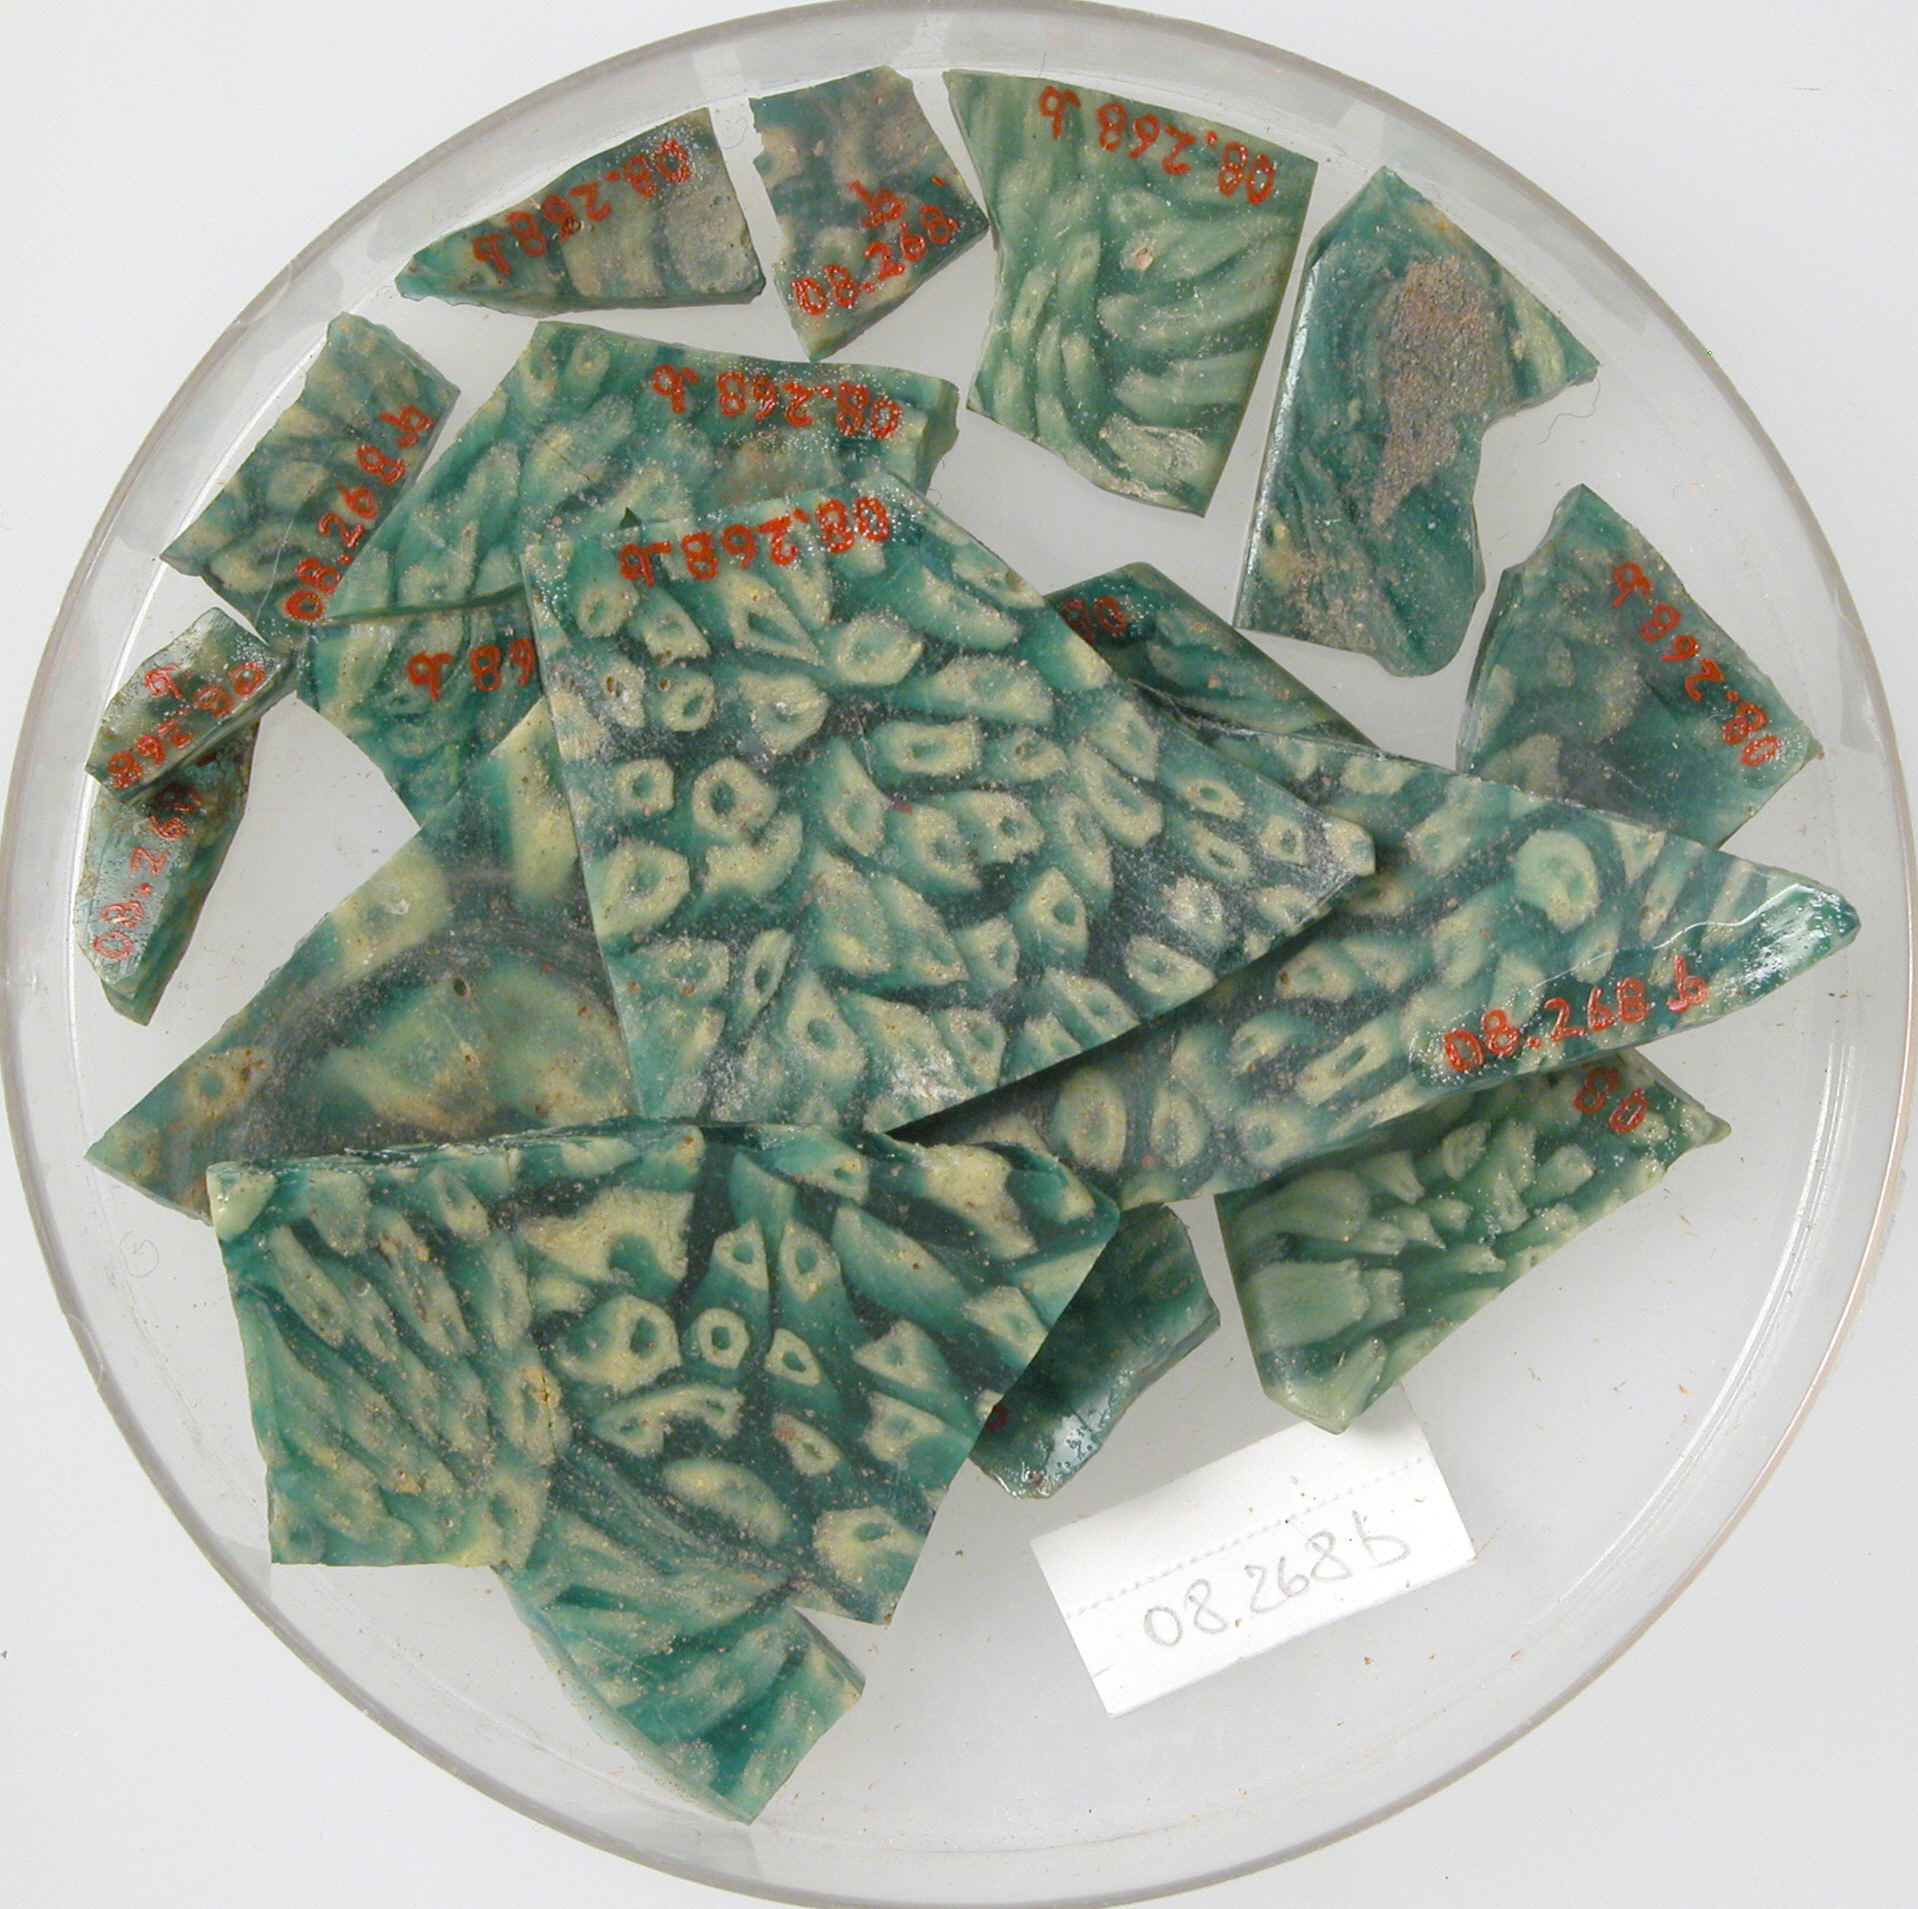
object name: fragment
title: Glass Fragments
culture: coptic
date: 301-433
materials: glass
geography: egypt